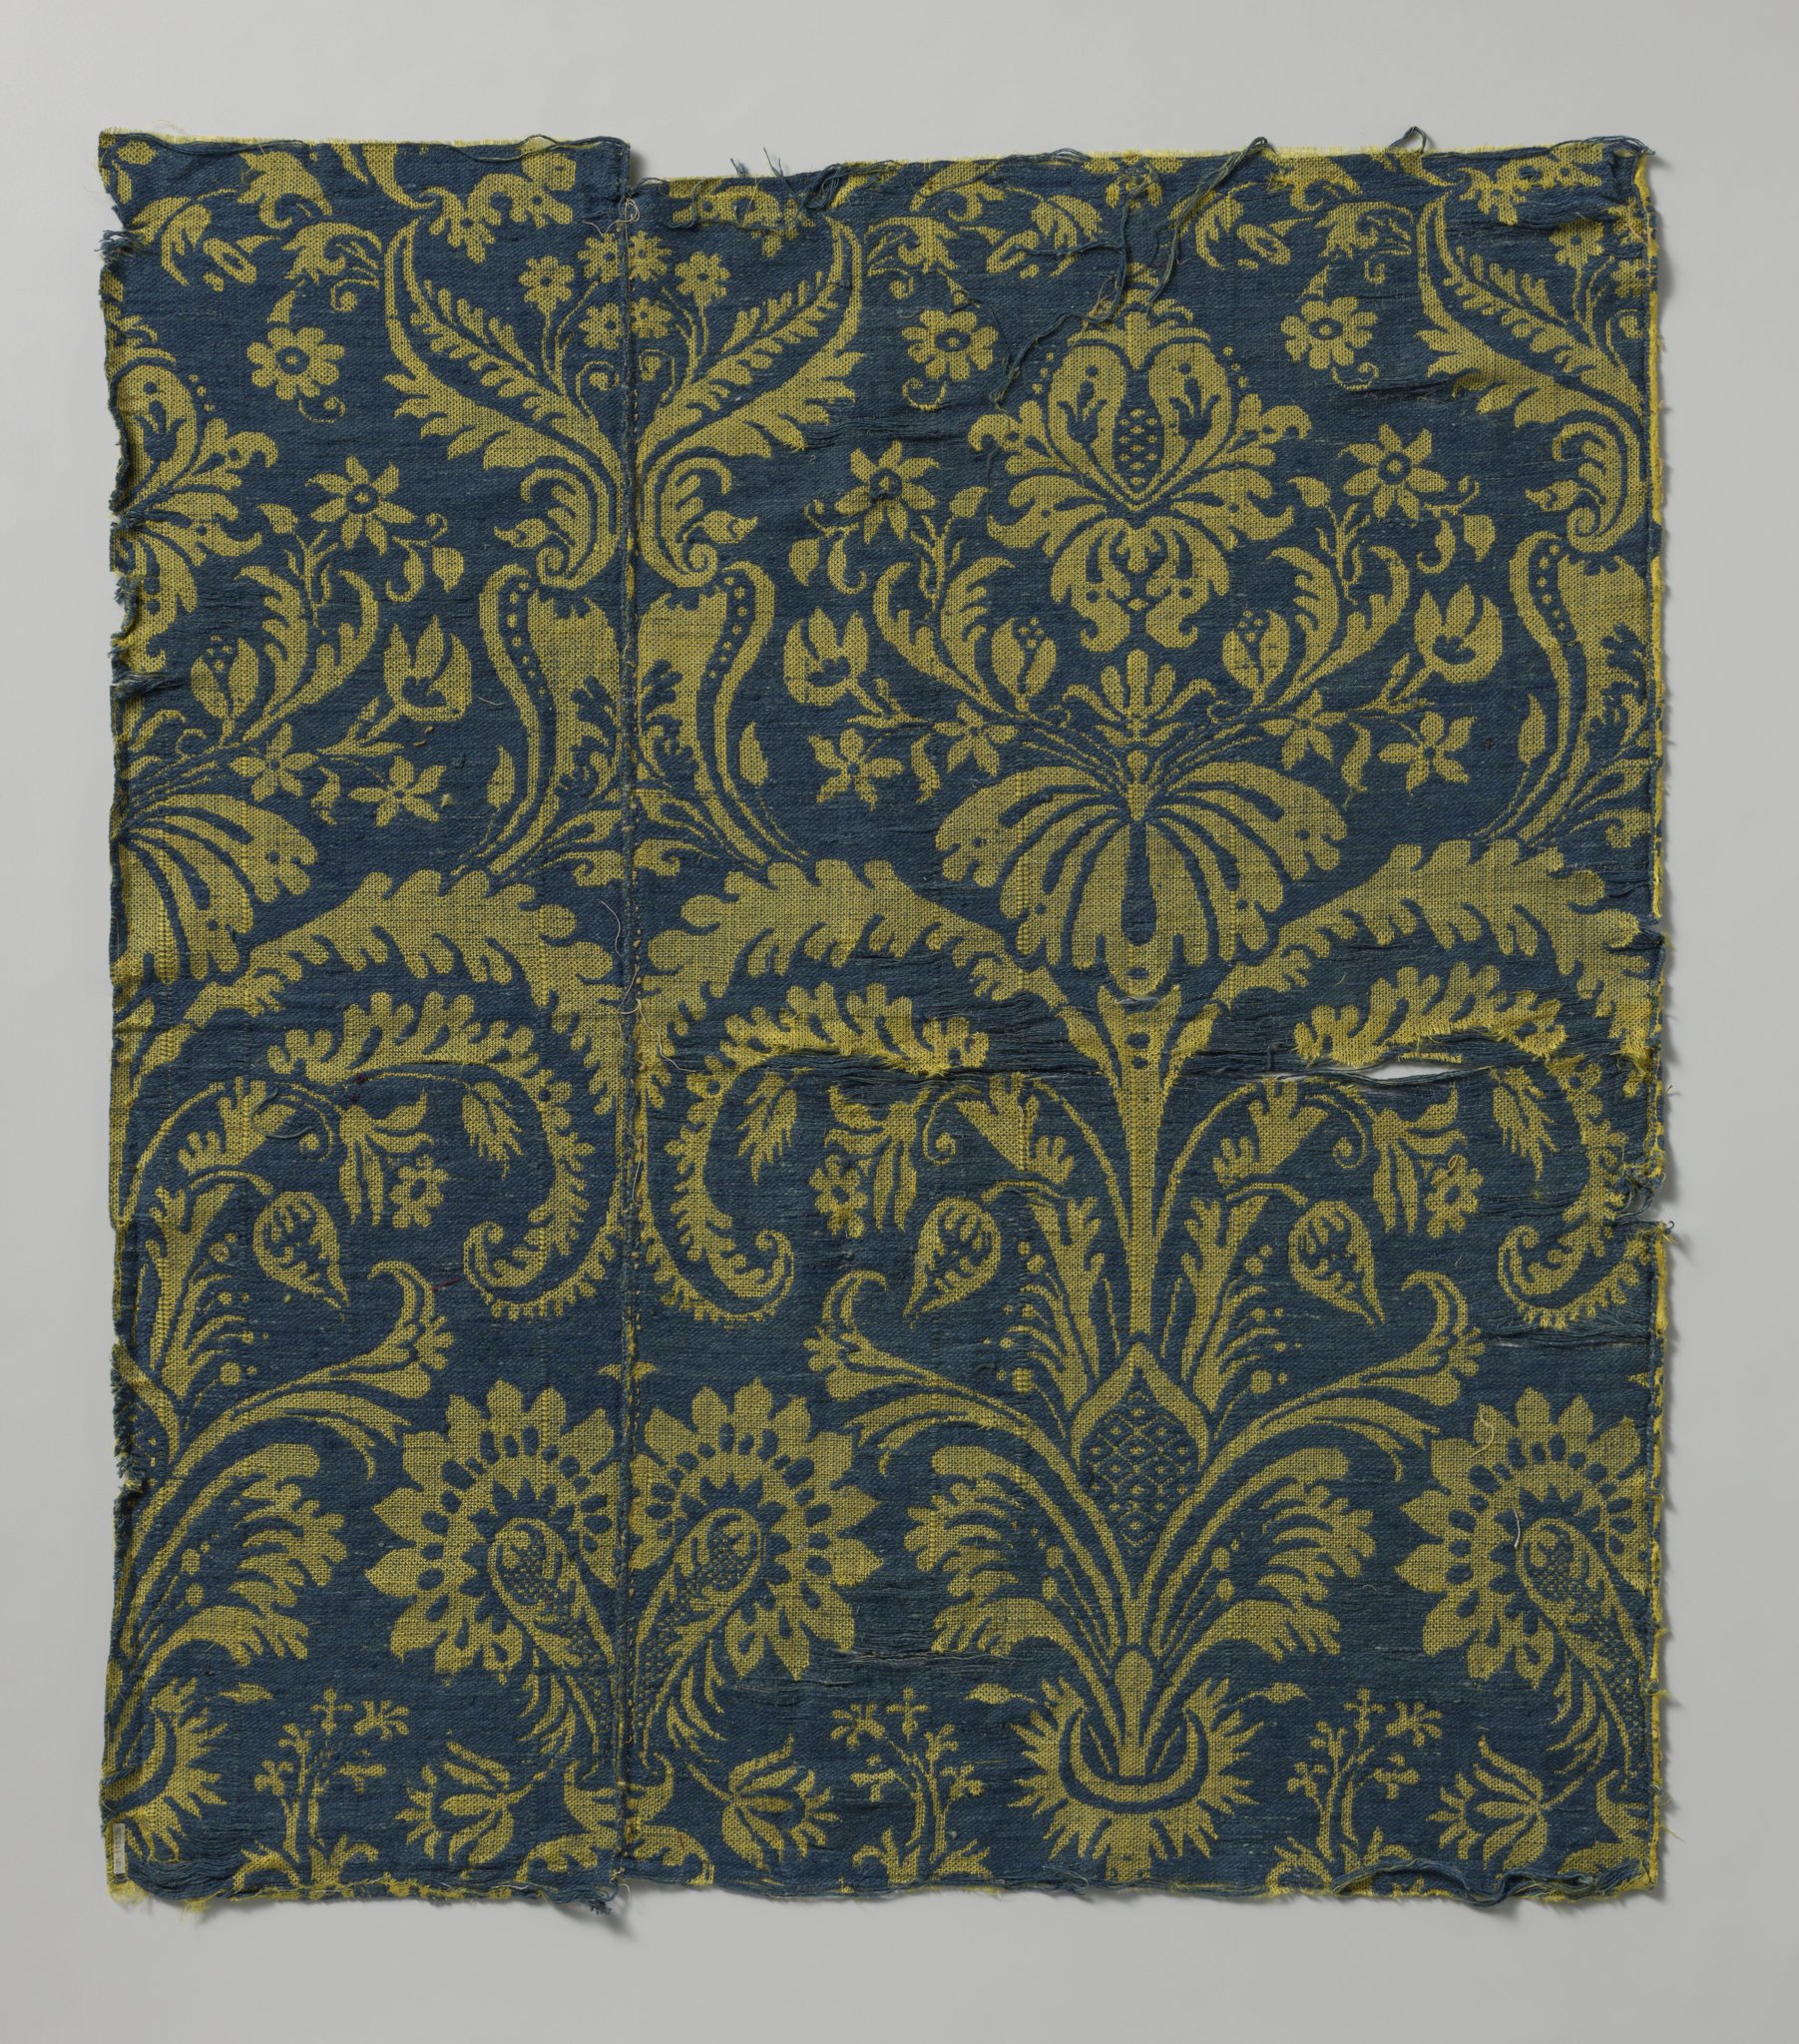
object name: fragment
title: Fragment geel en blauw gekleurd zijdeweefsel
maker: Anonymous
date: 1600-1699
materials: cotton, silk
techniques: lampas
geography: italy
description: Twee aan elkaar gezette fragmenten. Het patroon van blauw is een symetrisch renaissance ornament, gestileerde ranken, bloemen en bladen op een fond van flottante geel zijden draden. Opmerking: De flottante gele draden zijn bij één fragment bijna geheel versleten.